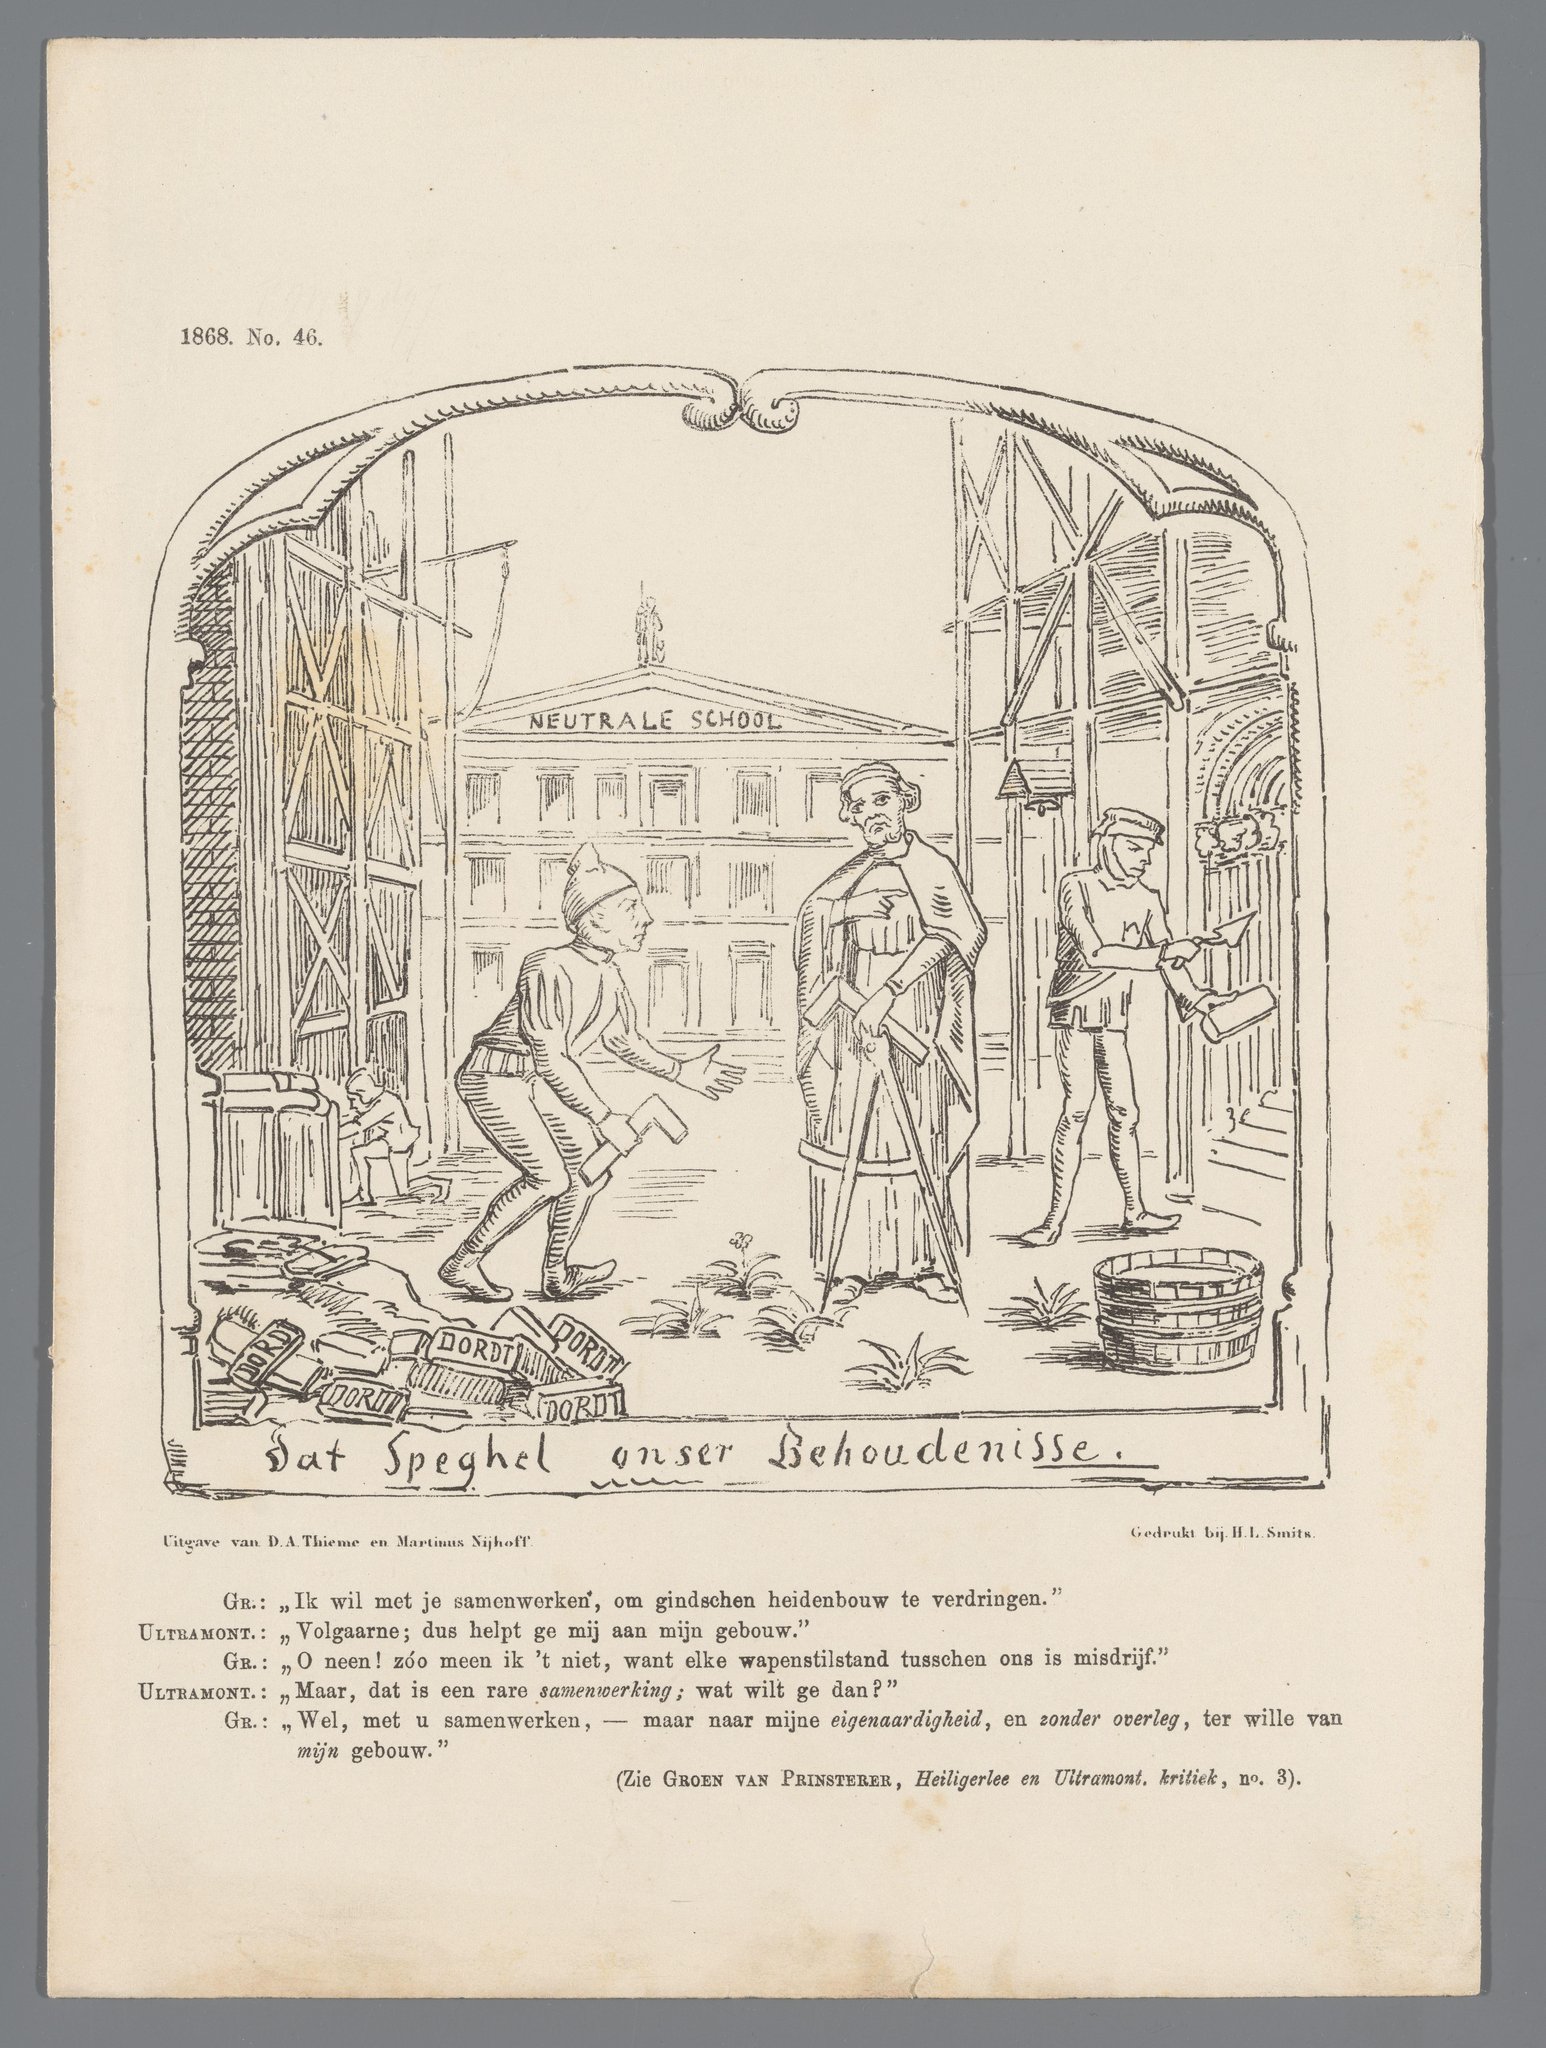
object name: print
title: Spotprent op de protesten tegen openbare lagere scholen, 1868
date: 1867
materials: paper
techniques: lithograph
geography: netherlands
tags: guillaume groen van prinsterer, building-site, elementary school; class, form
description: Spotprent op de pogingen van Groen van Prinsterer om zich met de ultamontaanse partij te verenigen tegen openbare lagere scholen. Plaat verschenen bij het weekblad De Nederlandsche Spectator, nr. 46, 14 november 1868.